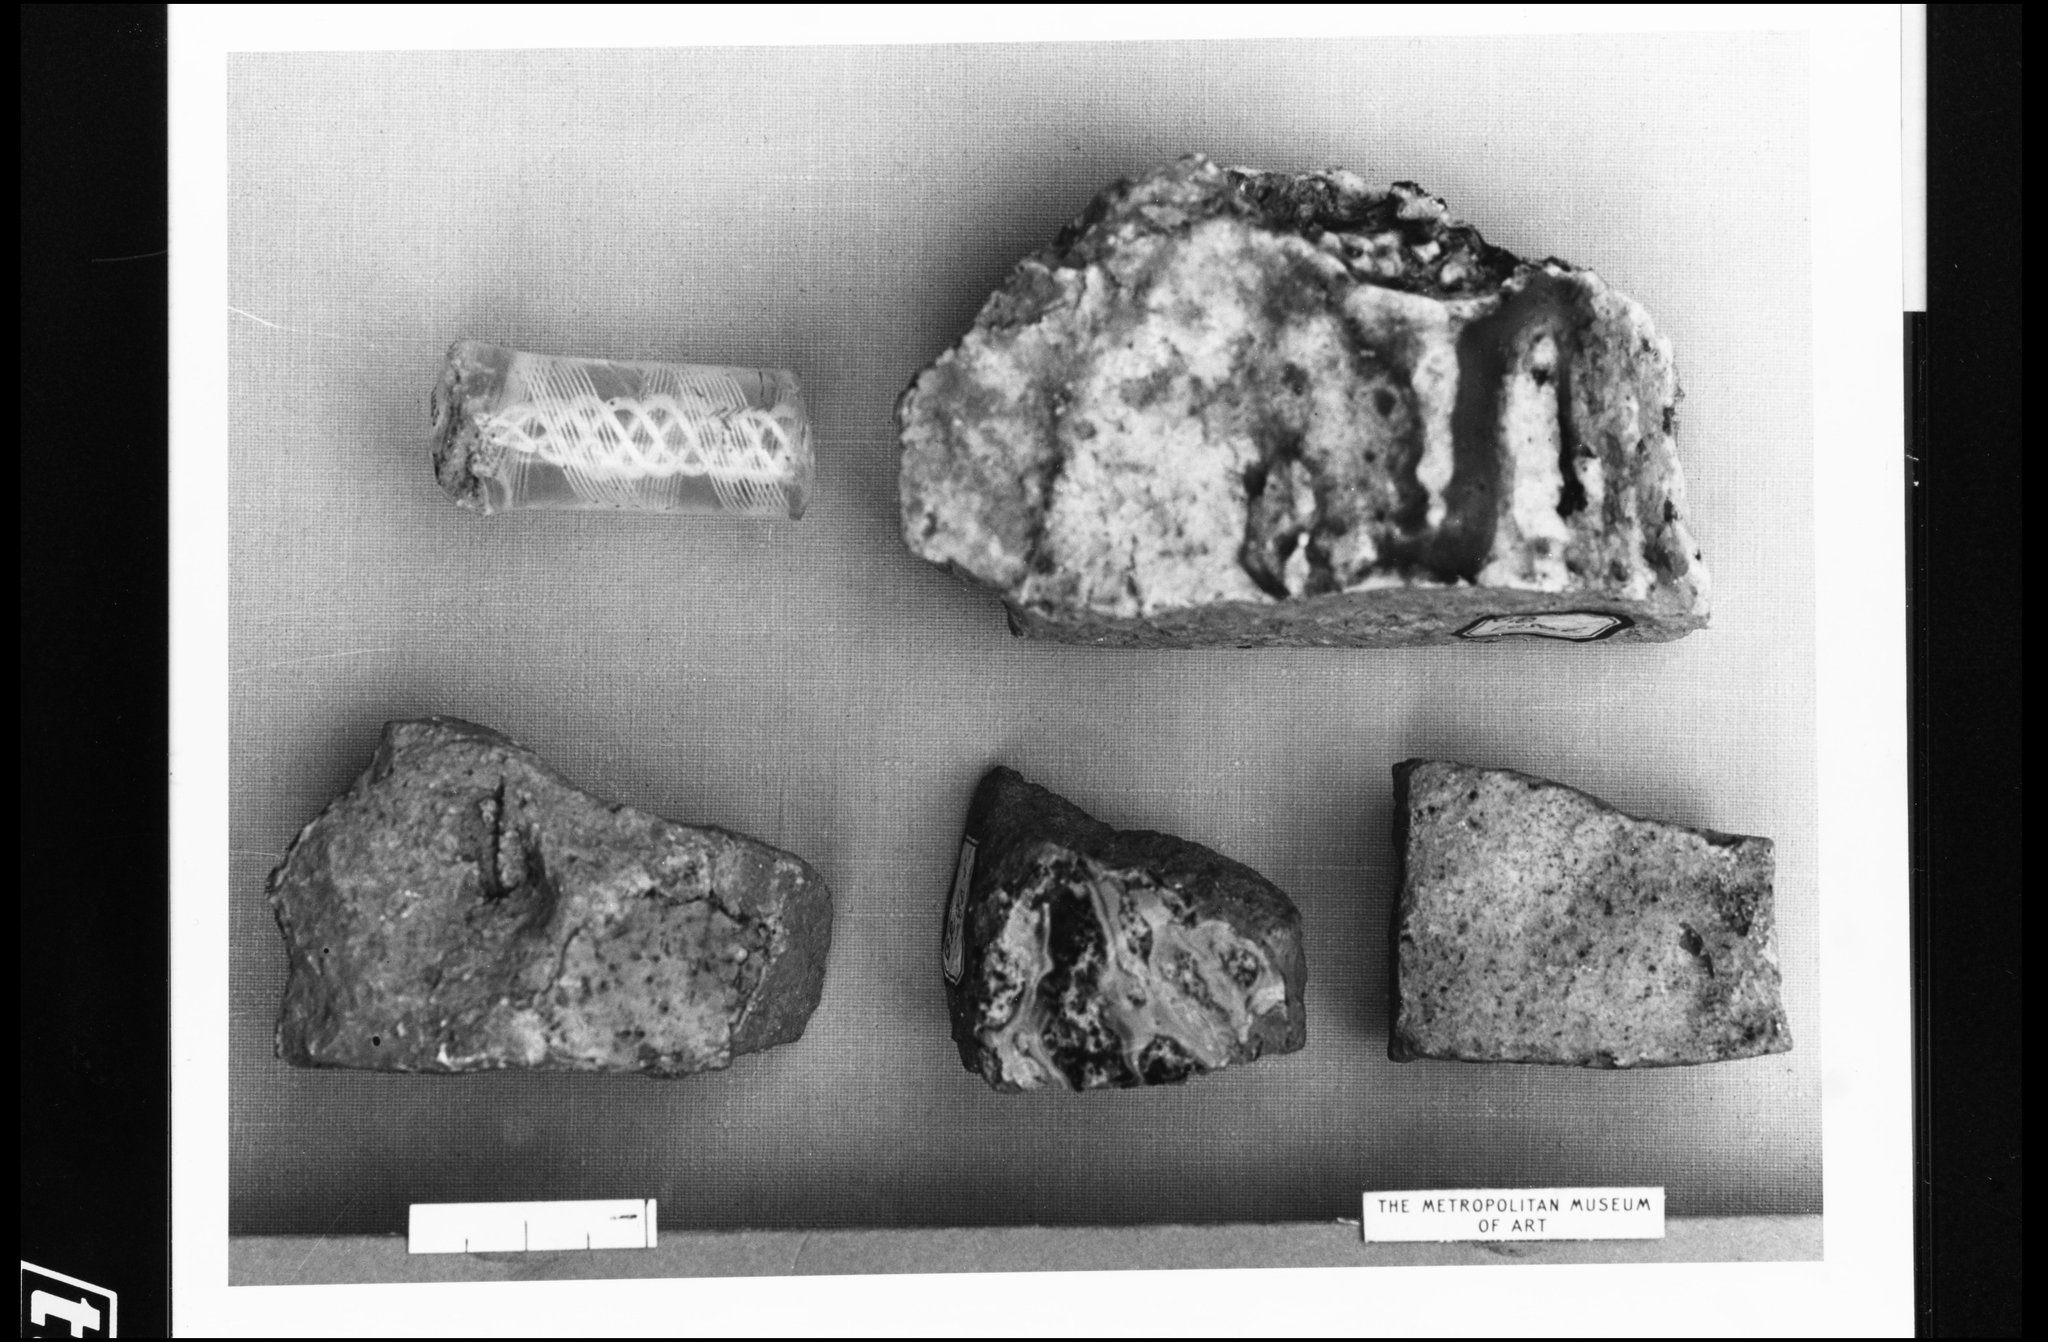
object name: fragment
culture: american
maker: stiegel's manheim factory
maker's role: maker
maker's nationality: american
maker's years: 1763-1774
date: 1763-1774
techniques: glassblowing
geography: united states